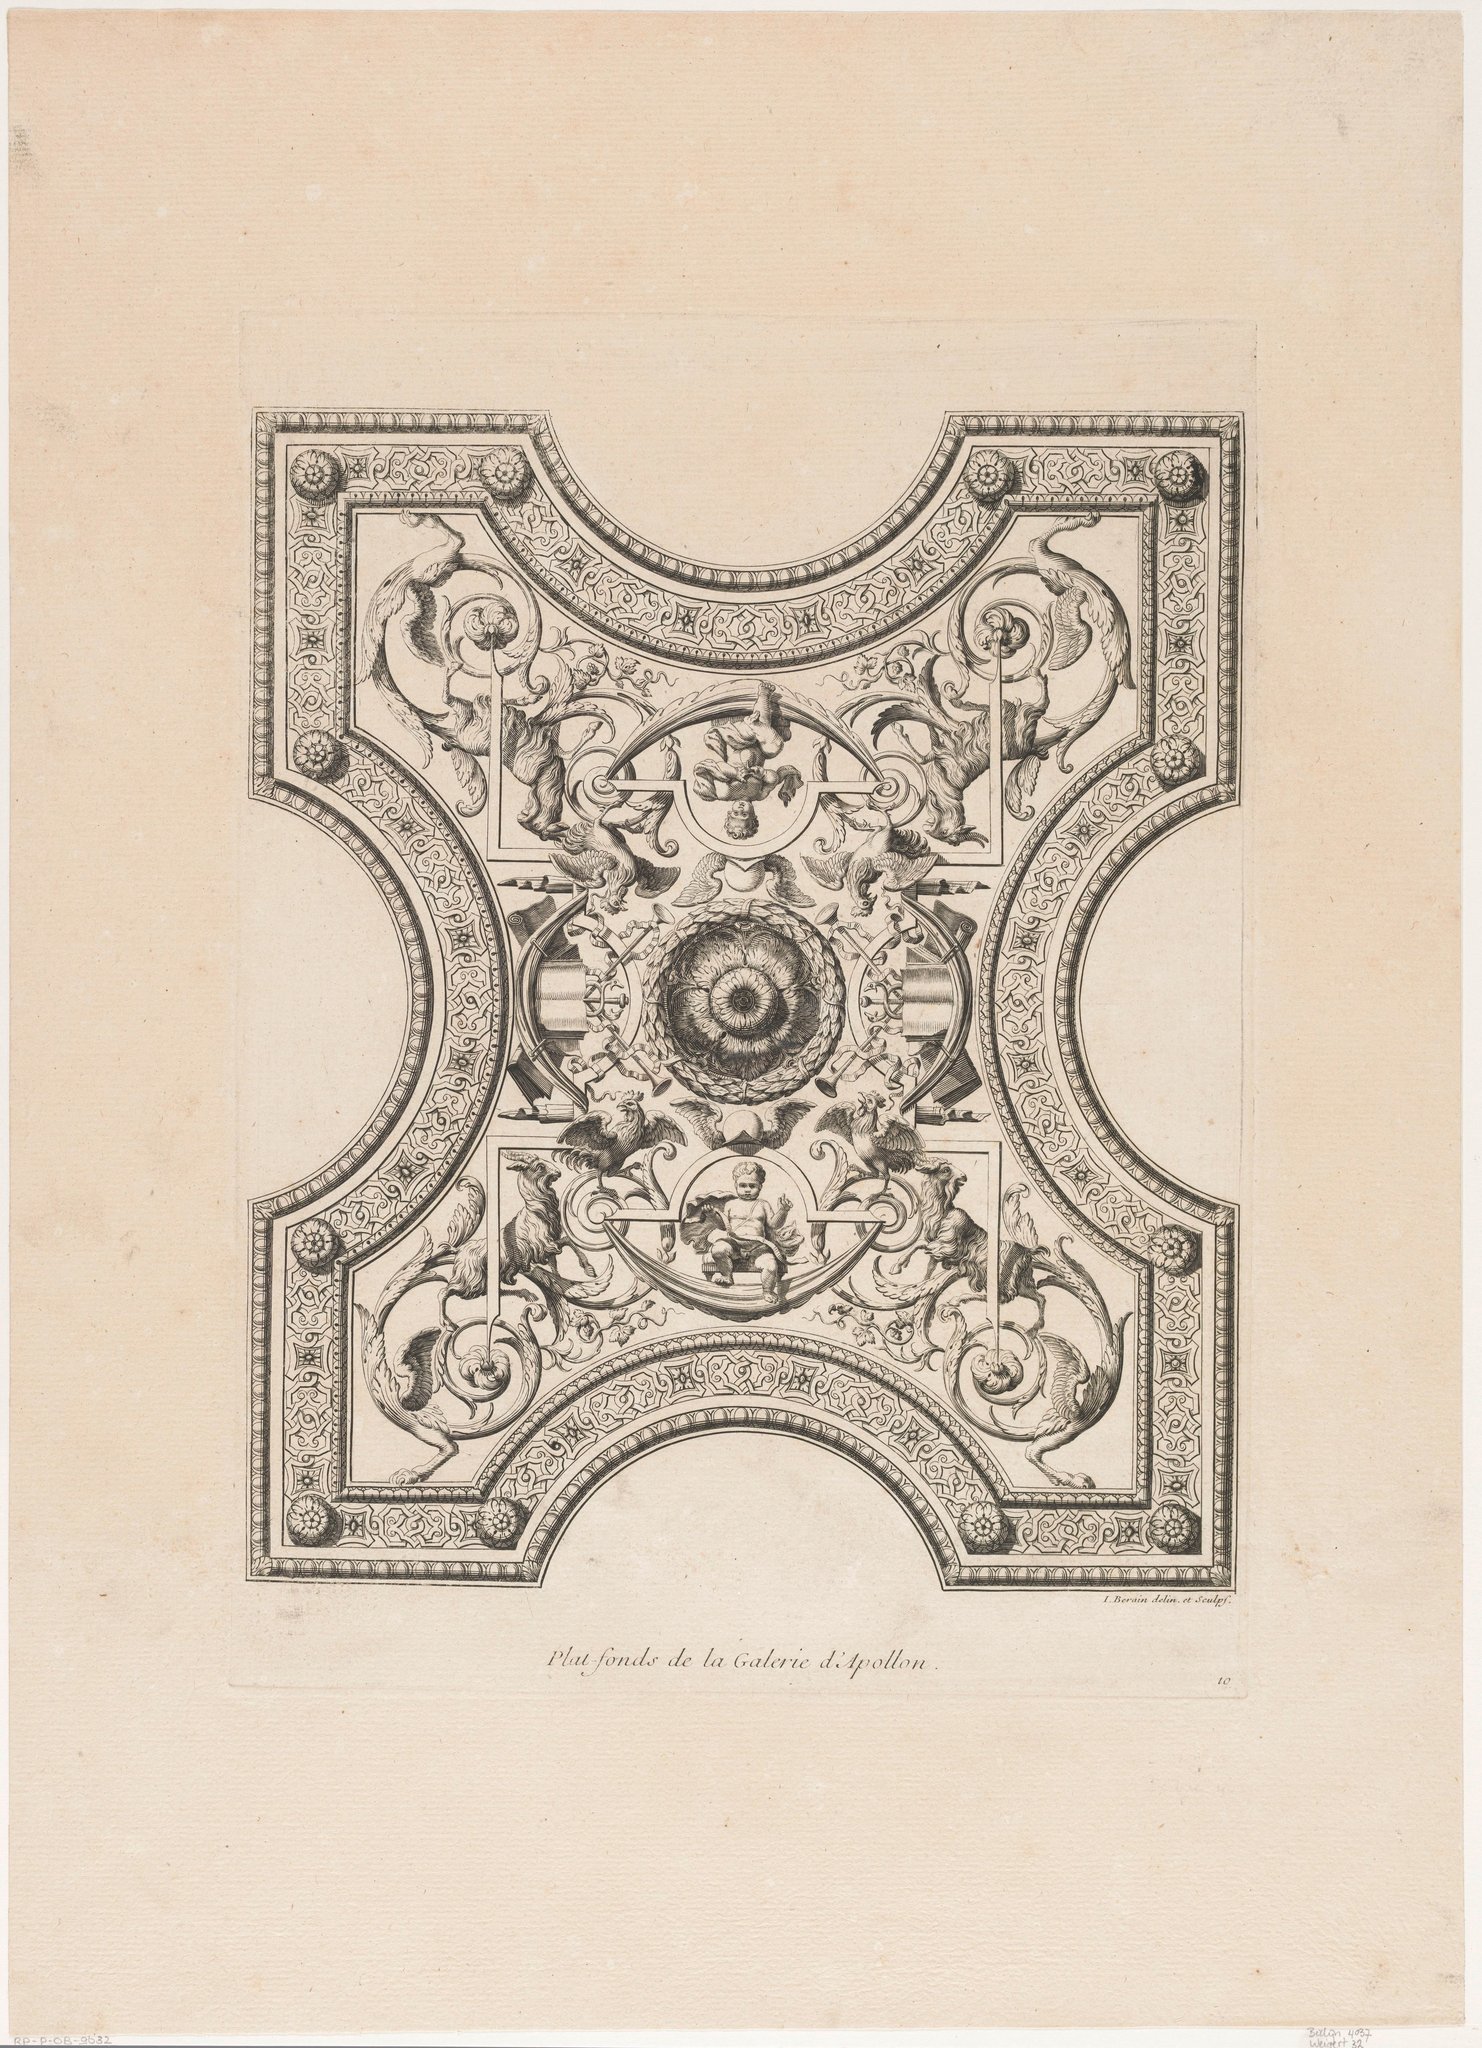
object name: ornament print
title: Plafond met hanen, putti en geiten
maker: jean berain (le vieux)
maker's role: print maker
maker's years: 1640-1711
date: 1670-1678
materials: paper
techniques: engraving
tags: fowl (cock, hen, chicken, etc.), (decorated) ceiling, goat, cupids: 'amores', 'amoretti', 'putti'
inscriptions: collector's mark: Lugt 2228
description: Een geornamenteerd plafond met in het midden een rozet met lauwerkrans rondom. Trofeeën met boeken en bazuinen flankeren de rozet. Aan de onder- en bovenzijde twee hanen en twee geiten aan weerszijden van een putto op een guirlande. In de vier hoeken acanthusranken met leeuwenpoten.